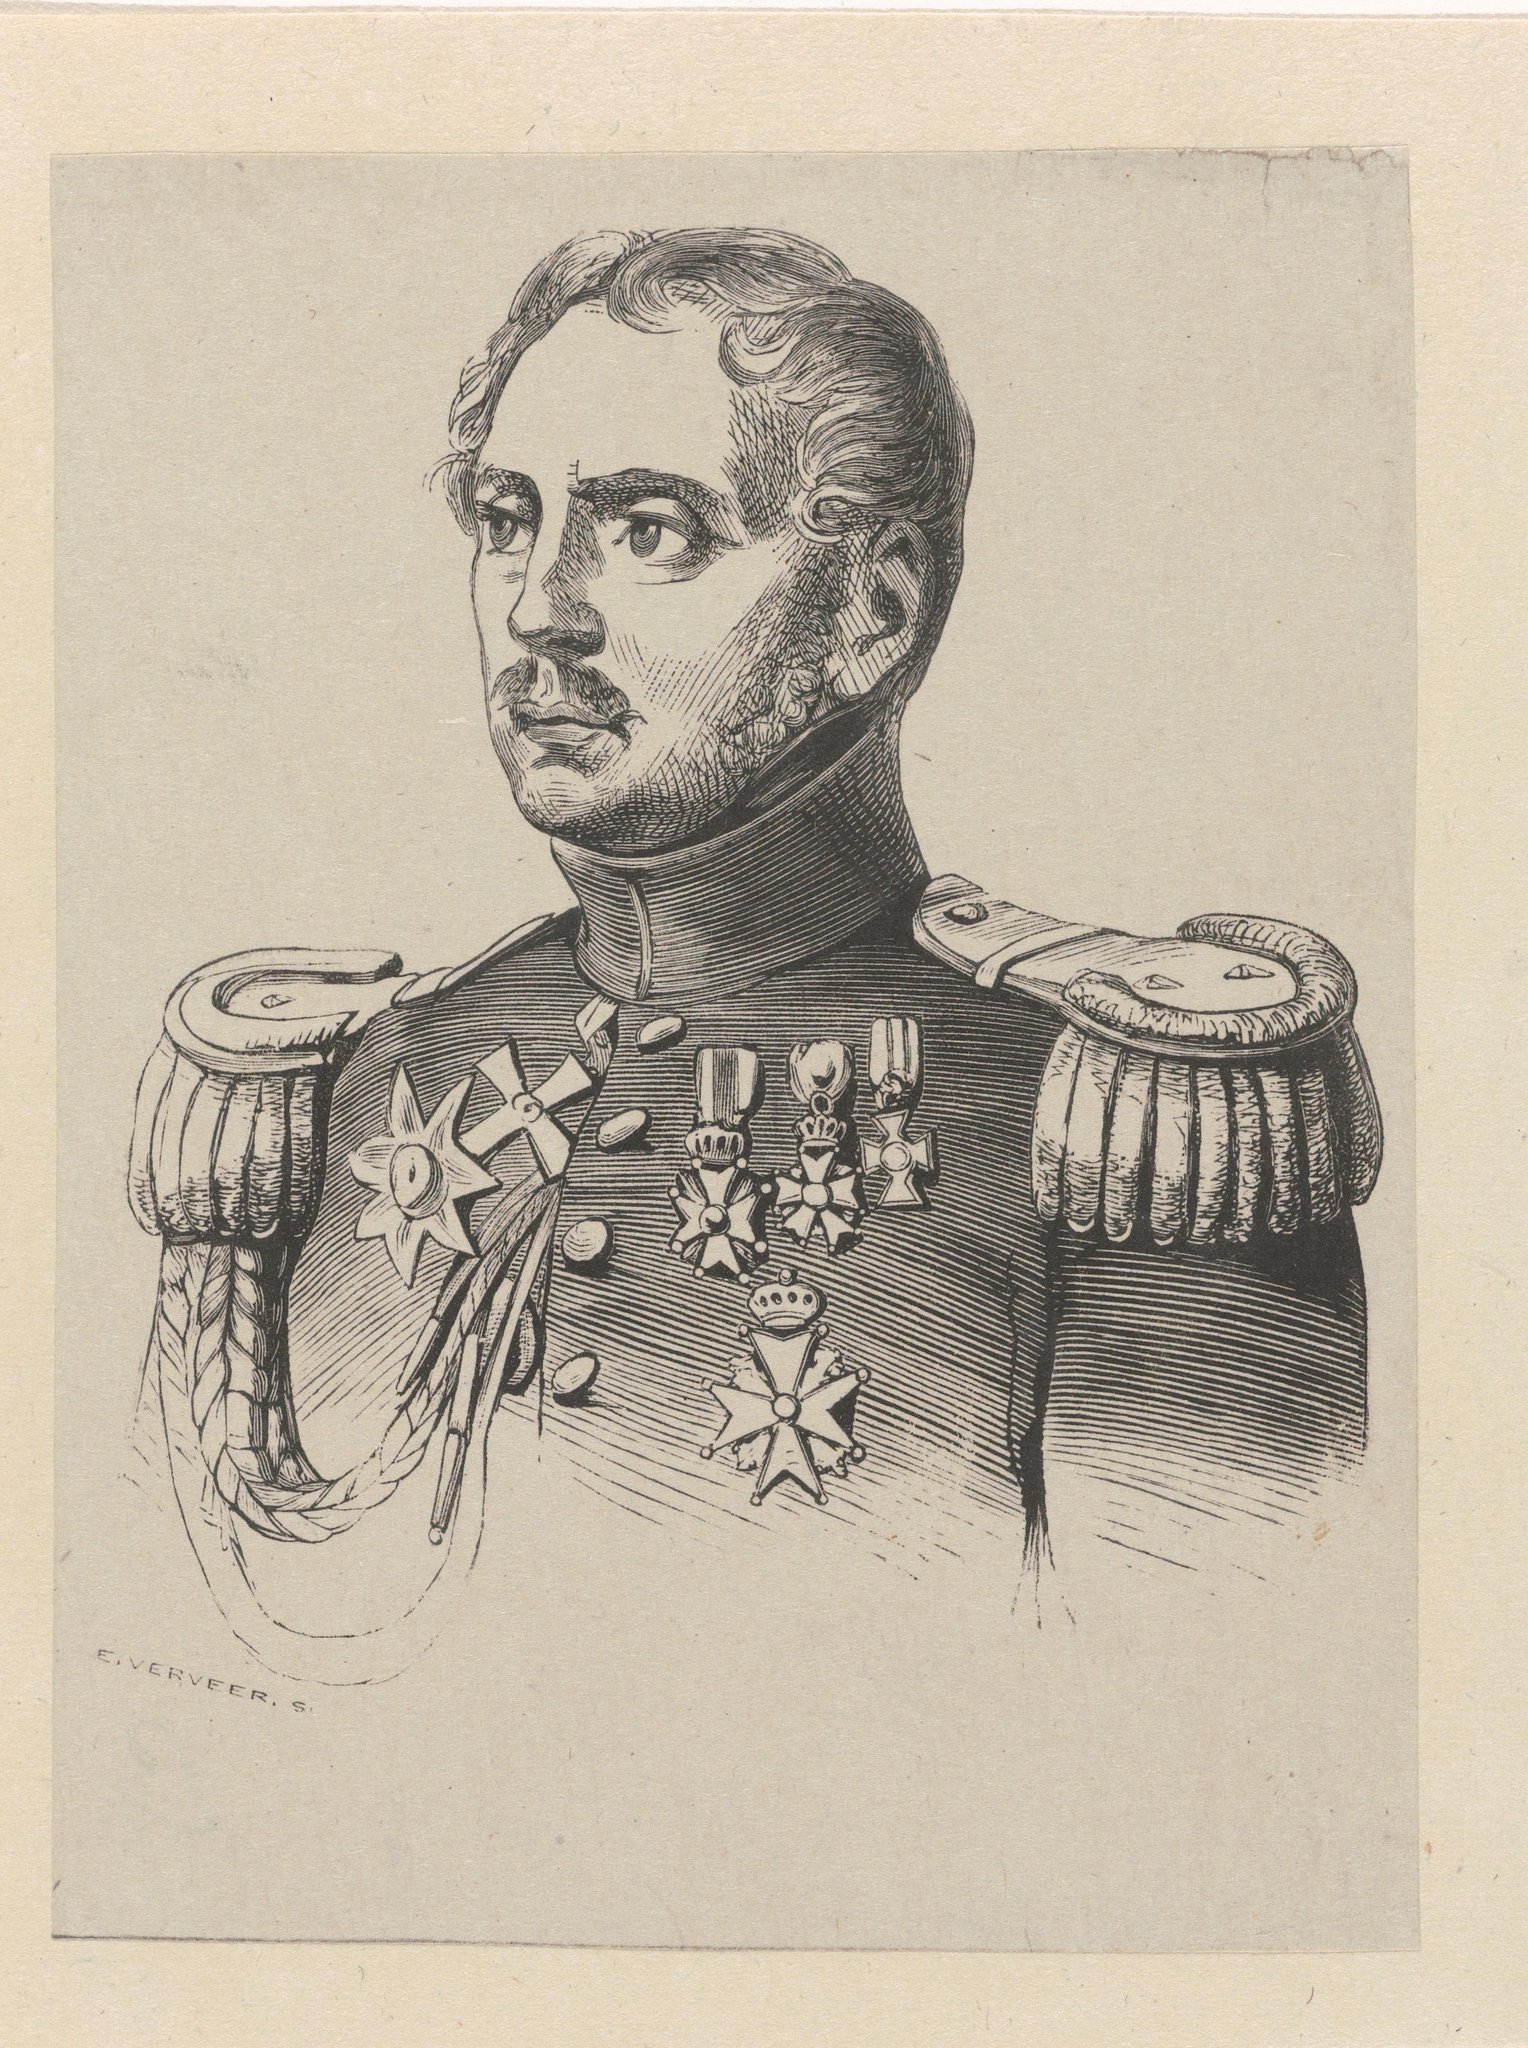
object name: print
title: Man in een militair kostuum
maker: elchanon verveer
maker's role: draughtsman, print maker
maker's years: 1826-1900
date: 1836-1900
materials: paper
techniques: engraving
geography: the hague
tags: (military) uniforms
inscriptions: collector's mark: Lugt 2228